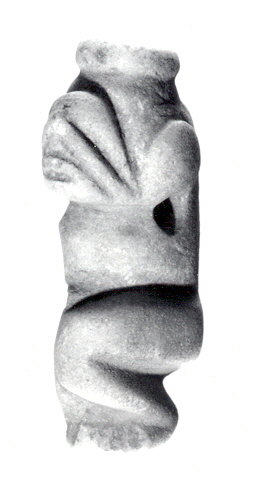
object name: pendant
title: Figure Pendant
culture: taíno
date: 901-1500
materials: stone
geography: dominican republic